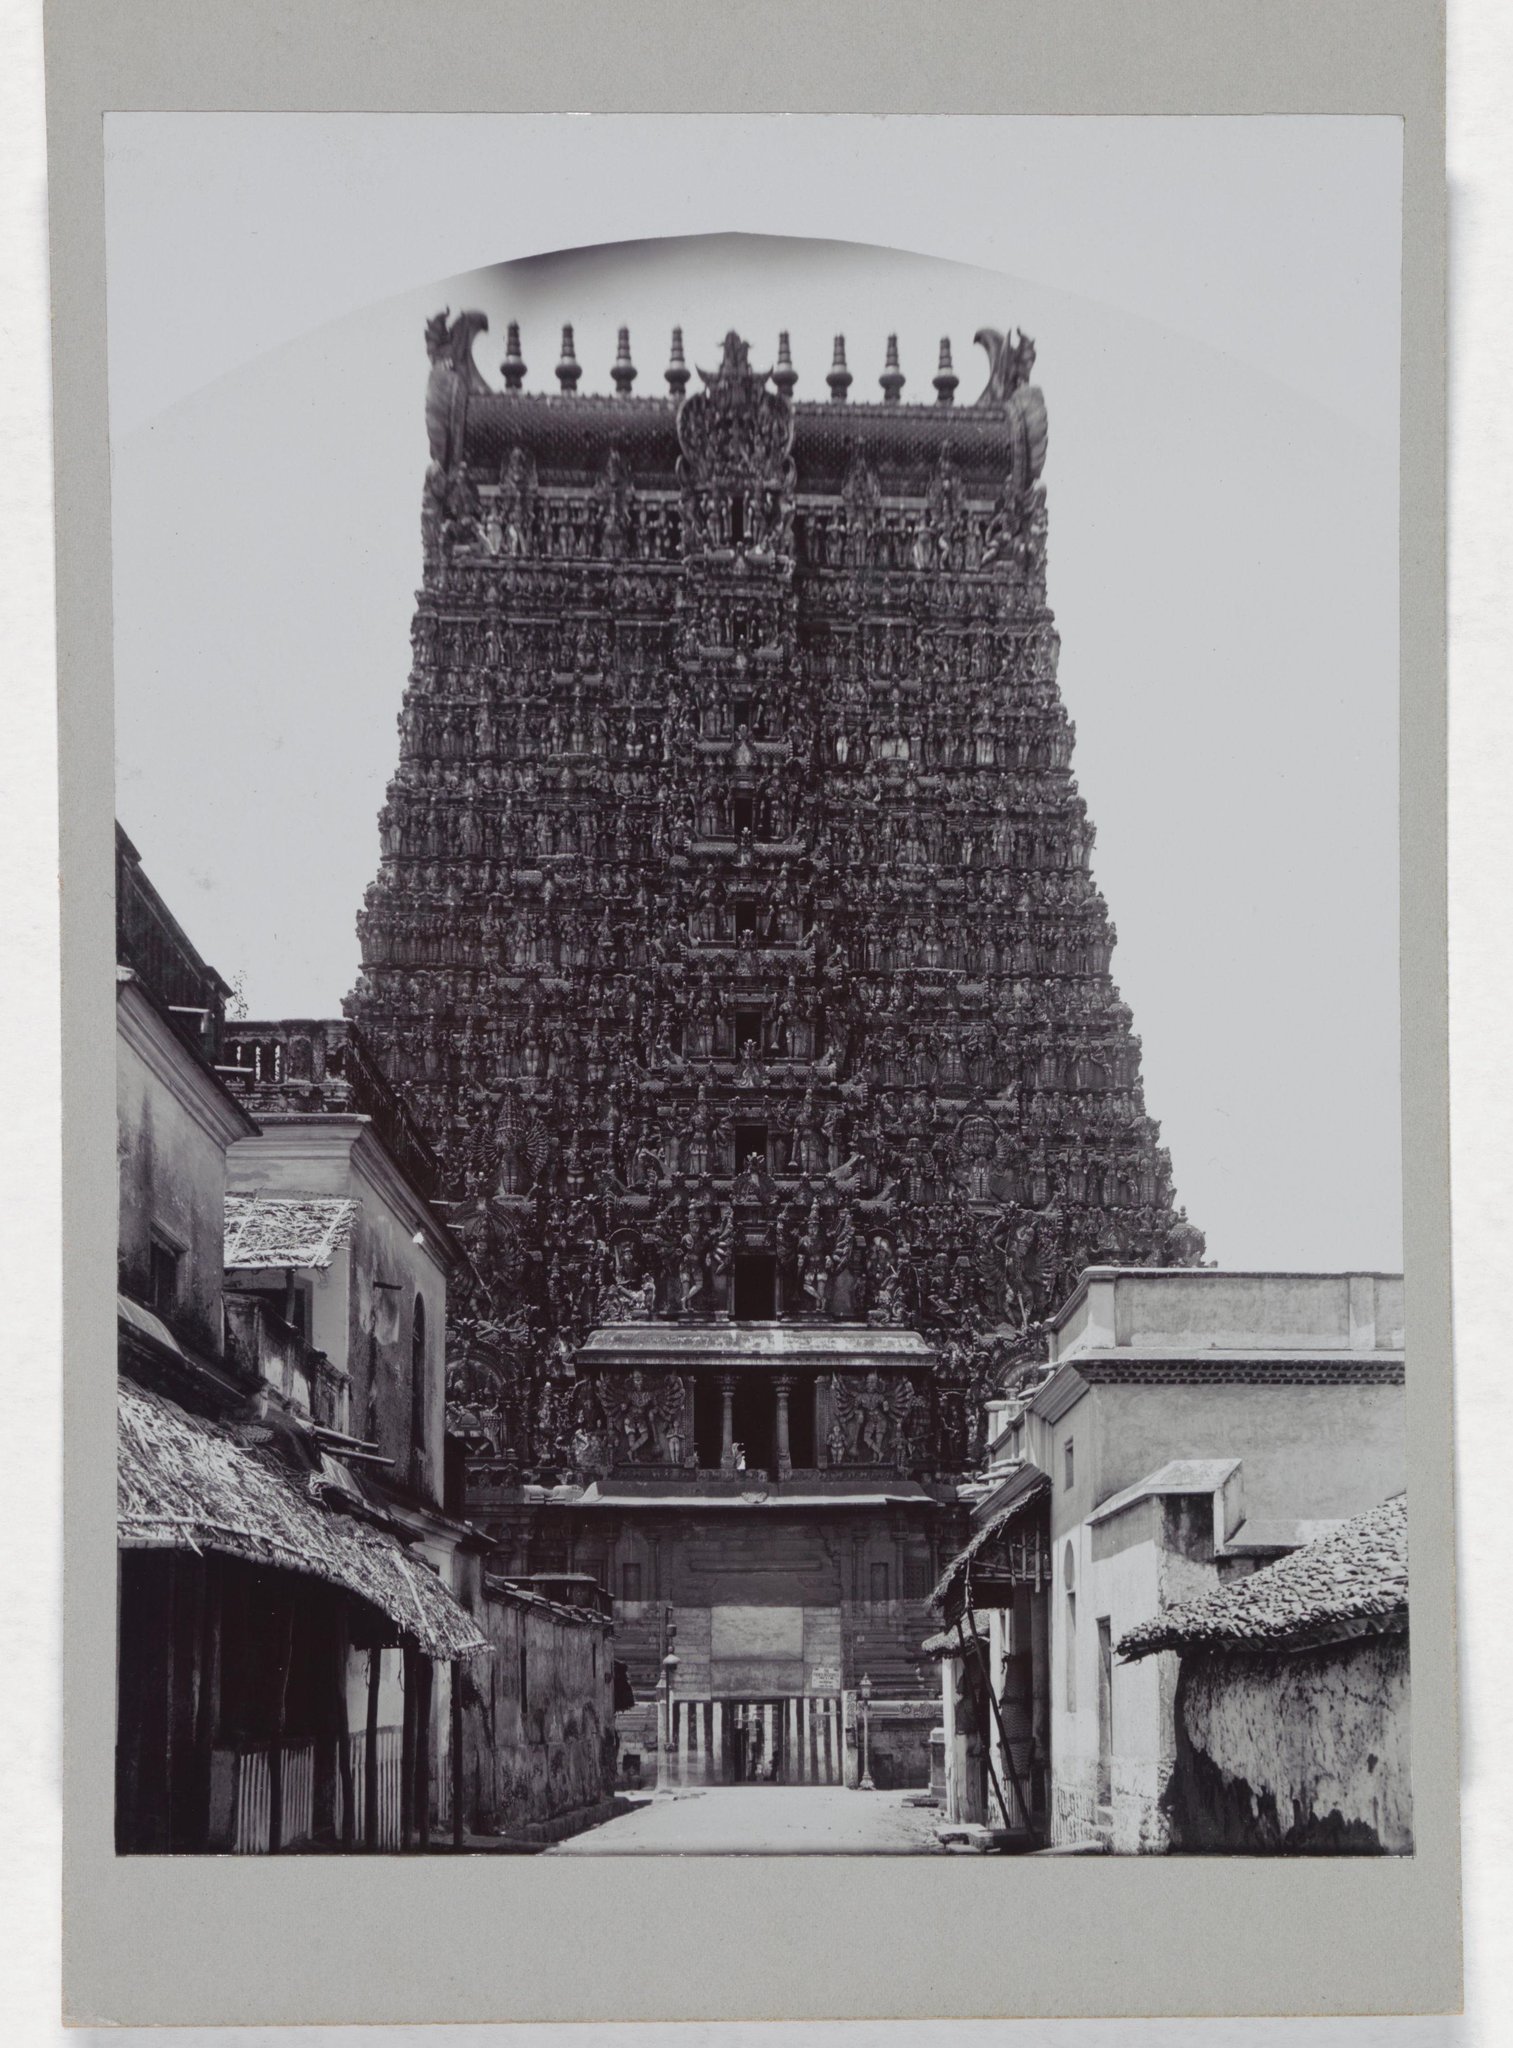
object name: photograph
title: Entrance to the Meenakshi temple at Madurai, Tamil Nadu, India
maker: Anonymous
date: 1895-1915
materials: cardboard, paper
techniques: gelatin silver print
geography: madurai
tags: madurai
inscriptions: annotation: ‘76a Ingang tot de tempel te Madura.’